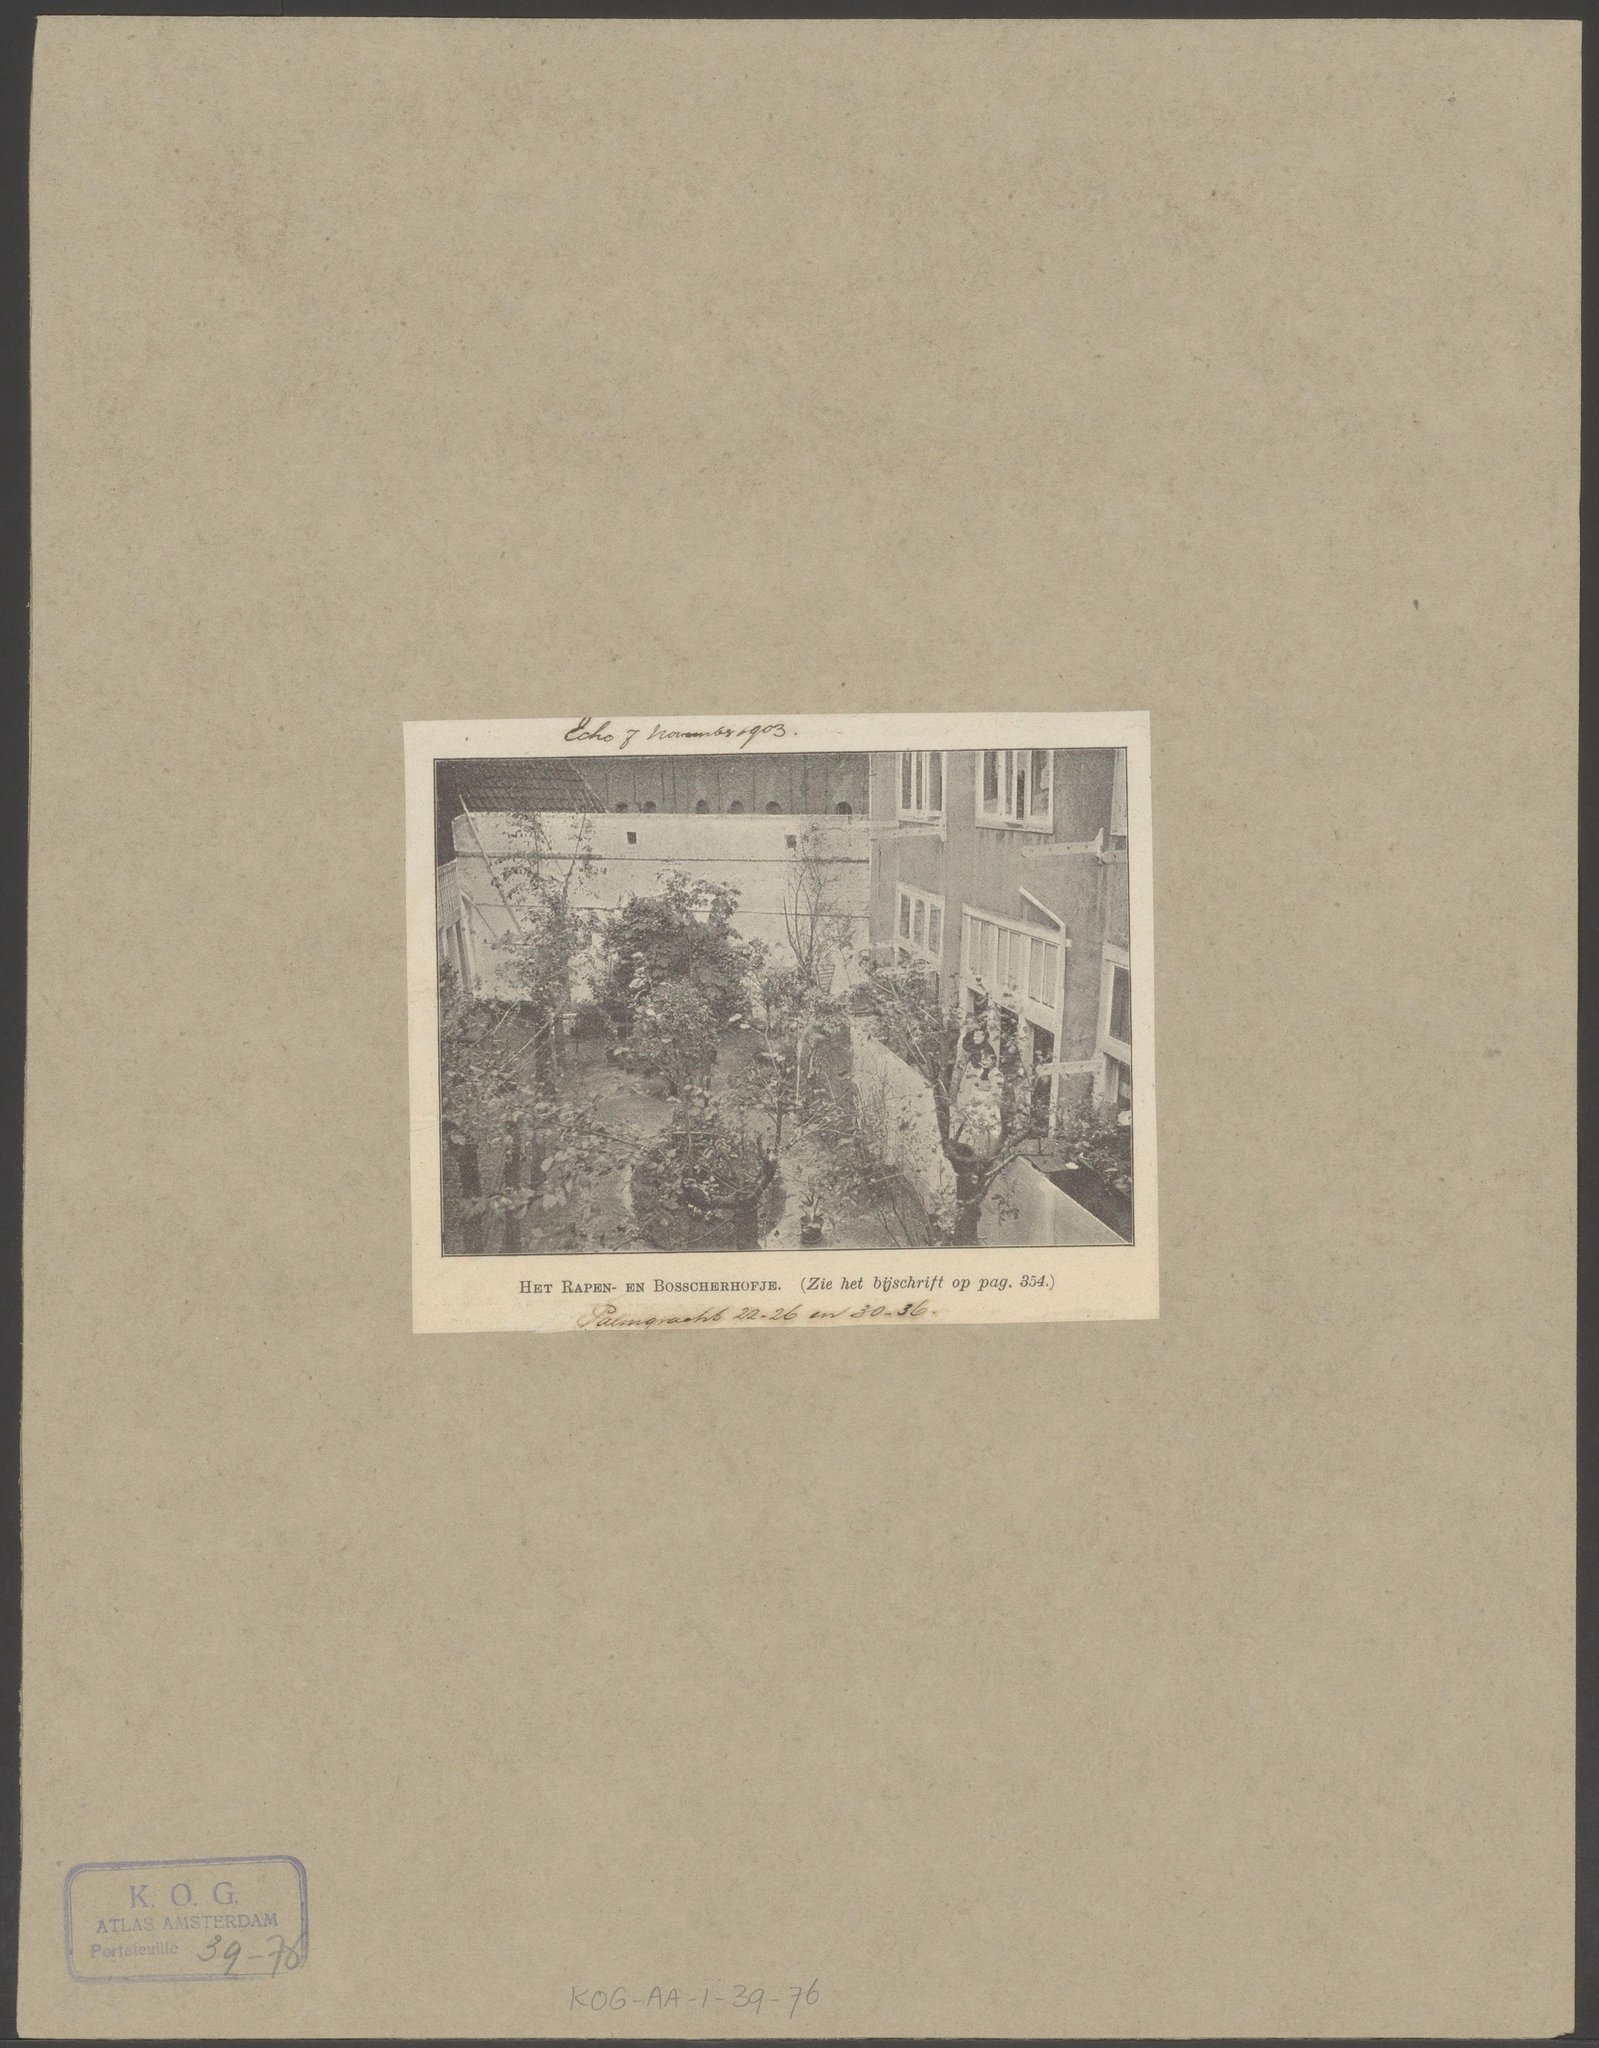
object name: photomechanical print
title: Het Rapen- en Bosscherhofje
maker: Anonymous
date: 1903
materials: paper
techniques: letterpress printing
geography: netherlands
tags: alms-house (dutch: 'hofje'), courtyard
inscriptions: collector's mark: Lugt 1641b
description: Onderwerpsrubriek binnen de Atlas Amsterdam: Armwezen en liefdadige instellingen: III. Verschillende gestichten en instellingen / Hofjes: Rapen- en Bosscherhofje - Regenboog's liefde Hofje - Rijper-Hofje.